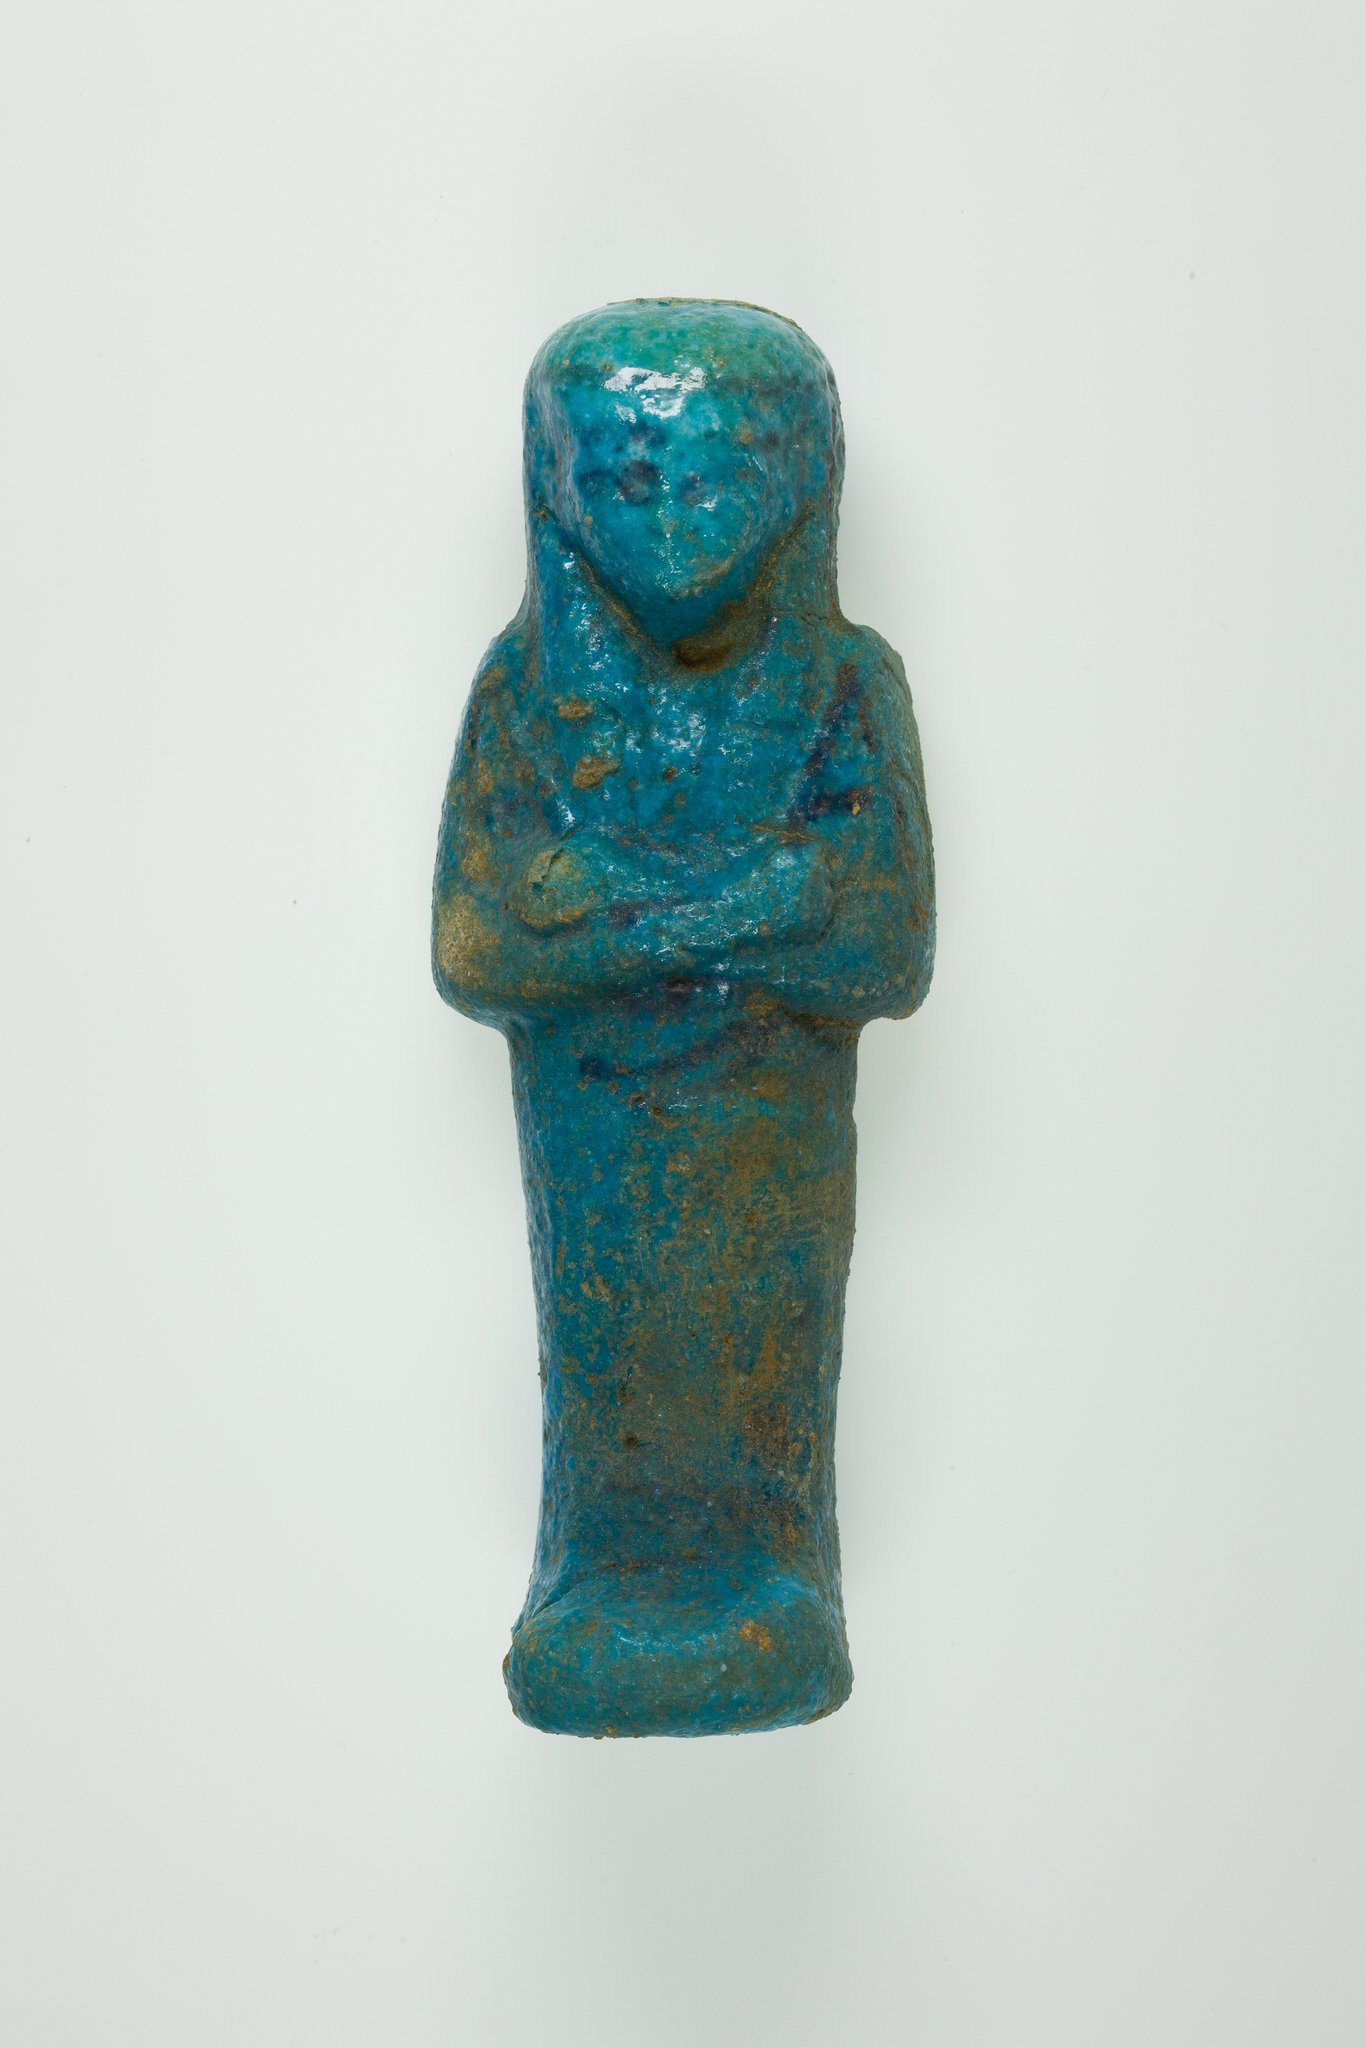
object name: worker shabti, henettawy c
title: Worker Shabti of Henettawy (C), Daughter of Isetemkheb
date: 990-970 BCE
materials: faience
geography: egypt